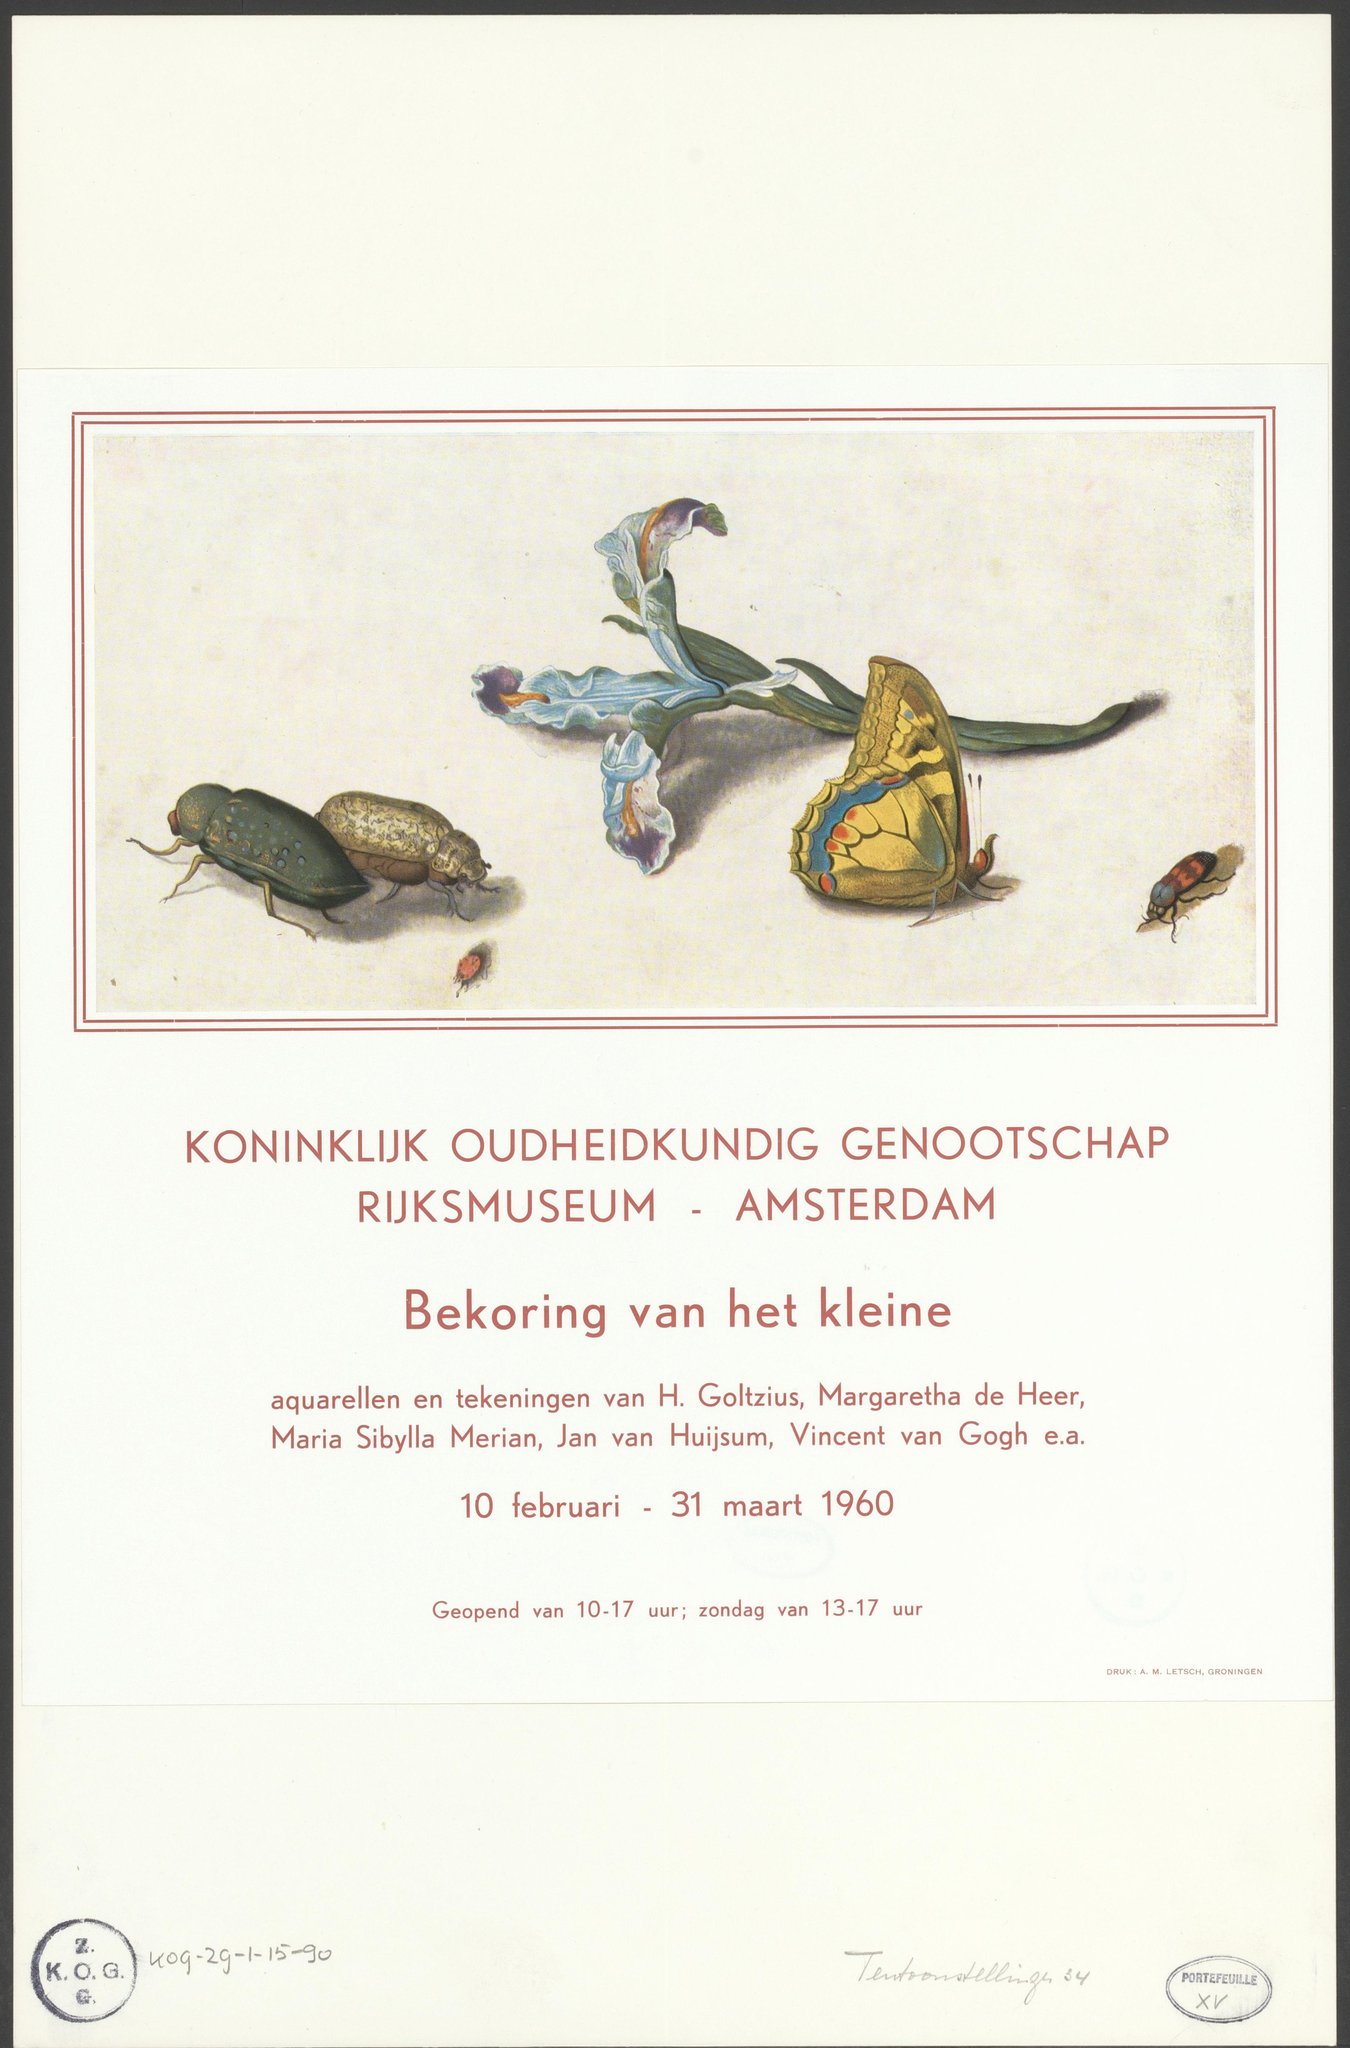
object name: poster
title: Tentoonstelling Bekoring van het kleine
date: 1959-1960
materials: paper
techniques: autotype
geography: haarlem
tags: jan van huysum, vincent van gogh, painter, print maker, draughtsman, hendrick goltzius, maria sibylla merian, flowers, insects: butterfly, insects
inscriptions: collector's mark: Lugt 1641, stamp:, collector's mark: Lugt 1641, stamp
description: Affiche voor de tentoonstelling Bekoring van het kleine van het Koninklijke Oudheidkundige Genootschap in het Rijksmuseum Amsterdam. Met tekeningen van Hendrick Goltzius, Margaretha de Heer, Maria Sibylla Merian, Jan van Huijsum, Vincent van Gogh e.a. De tentoonstelling vond plaats tussen 10 februari en 31 maart 1960. Onderwerpsrubrieken binnen de Atlas Zeden en Gewoonten: Handel, nijverheid en verkeer, Tentoonstellingen.